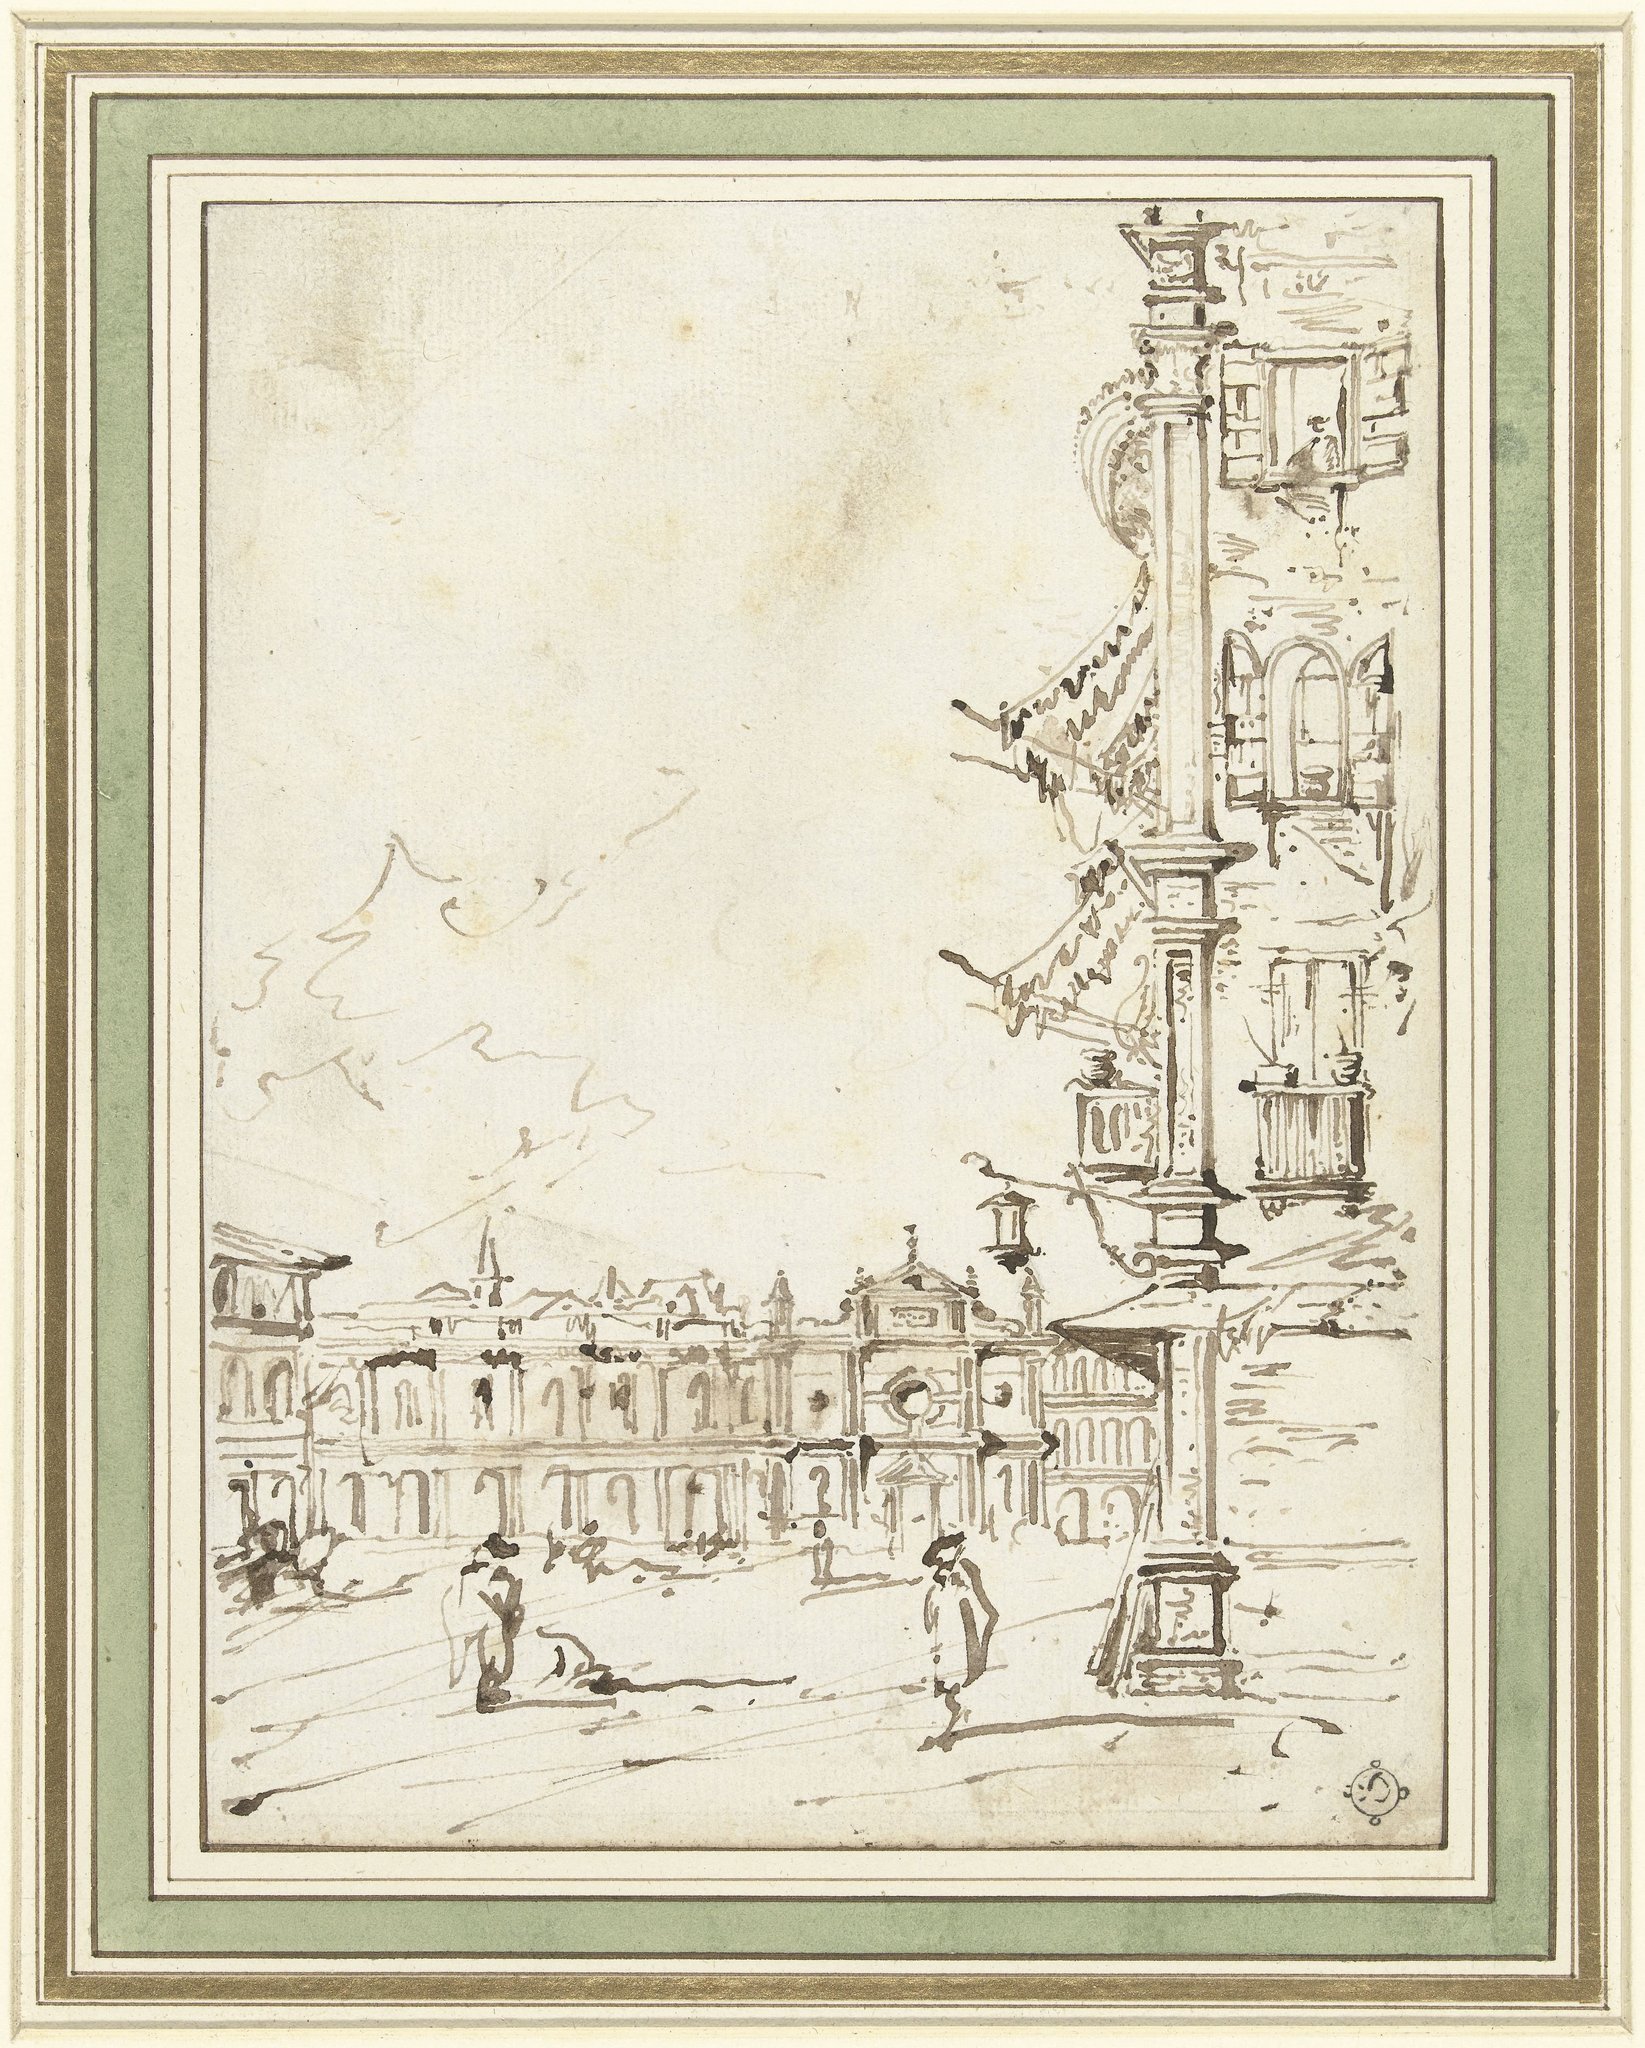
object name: drawing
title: Piazza San Marco te Venetië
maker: Anonymous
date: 1800-1900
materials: ink, paper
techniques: pen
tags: square, place, circus, etc., italy, venice